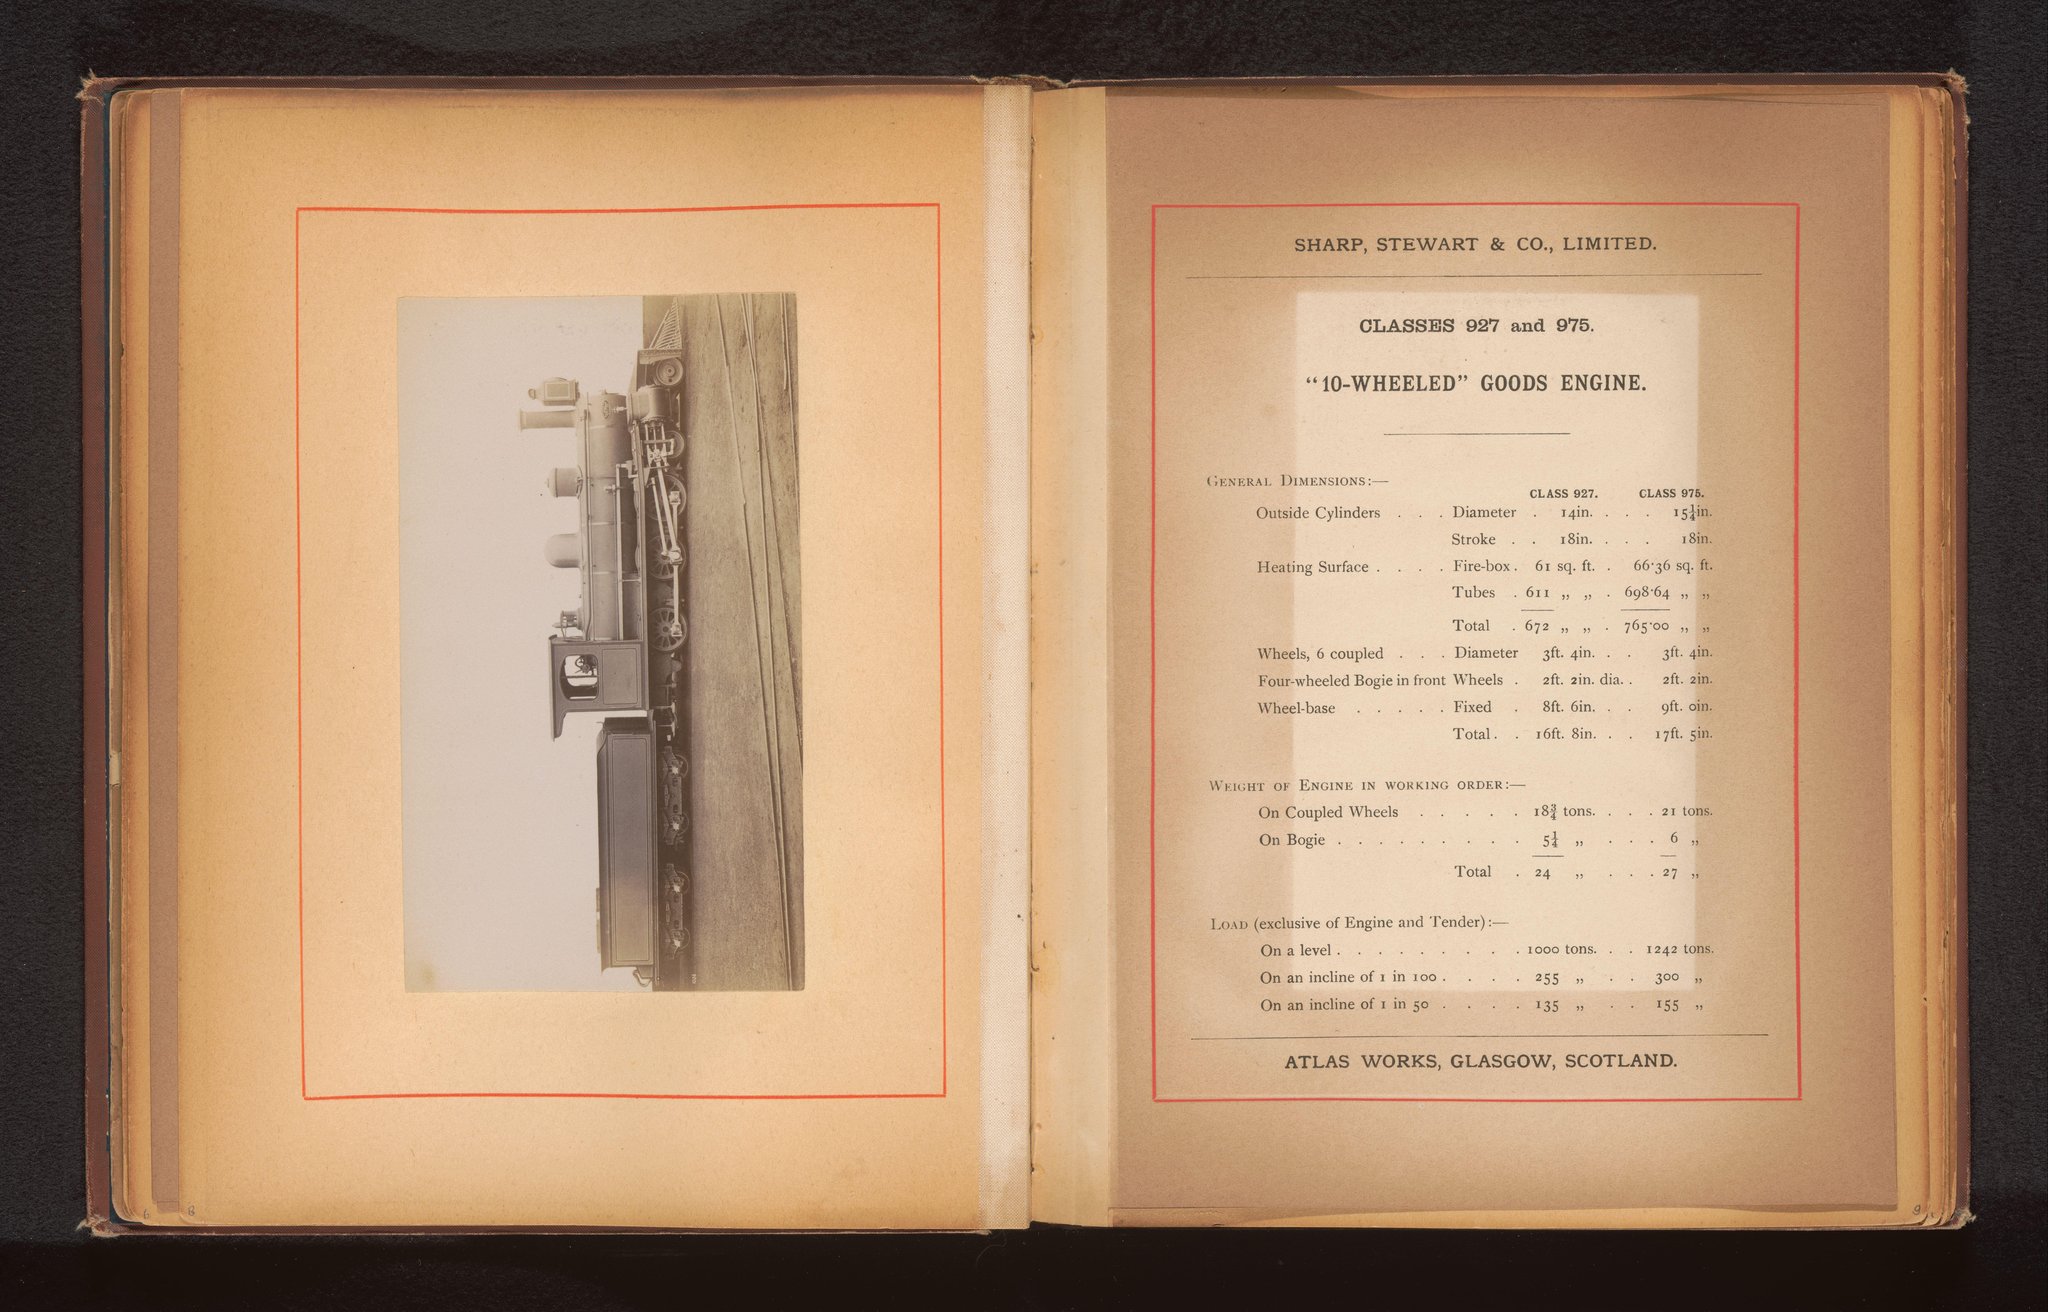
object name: page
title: Stoomlocomotief met tien wielen voor goederenvervoer, gemaakt door Sharp, Stewart and Company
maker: Anonymous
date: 1874-1884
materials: photographic support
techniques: albumen print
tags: steam locomotive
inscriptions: inscription: ‘Classes 927 and 975. “10-wheeled” goods engine.’, number: ‘1008’